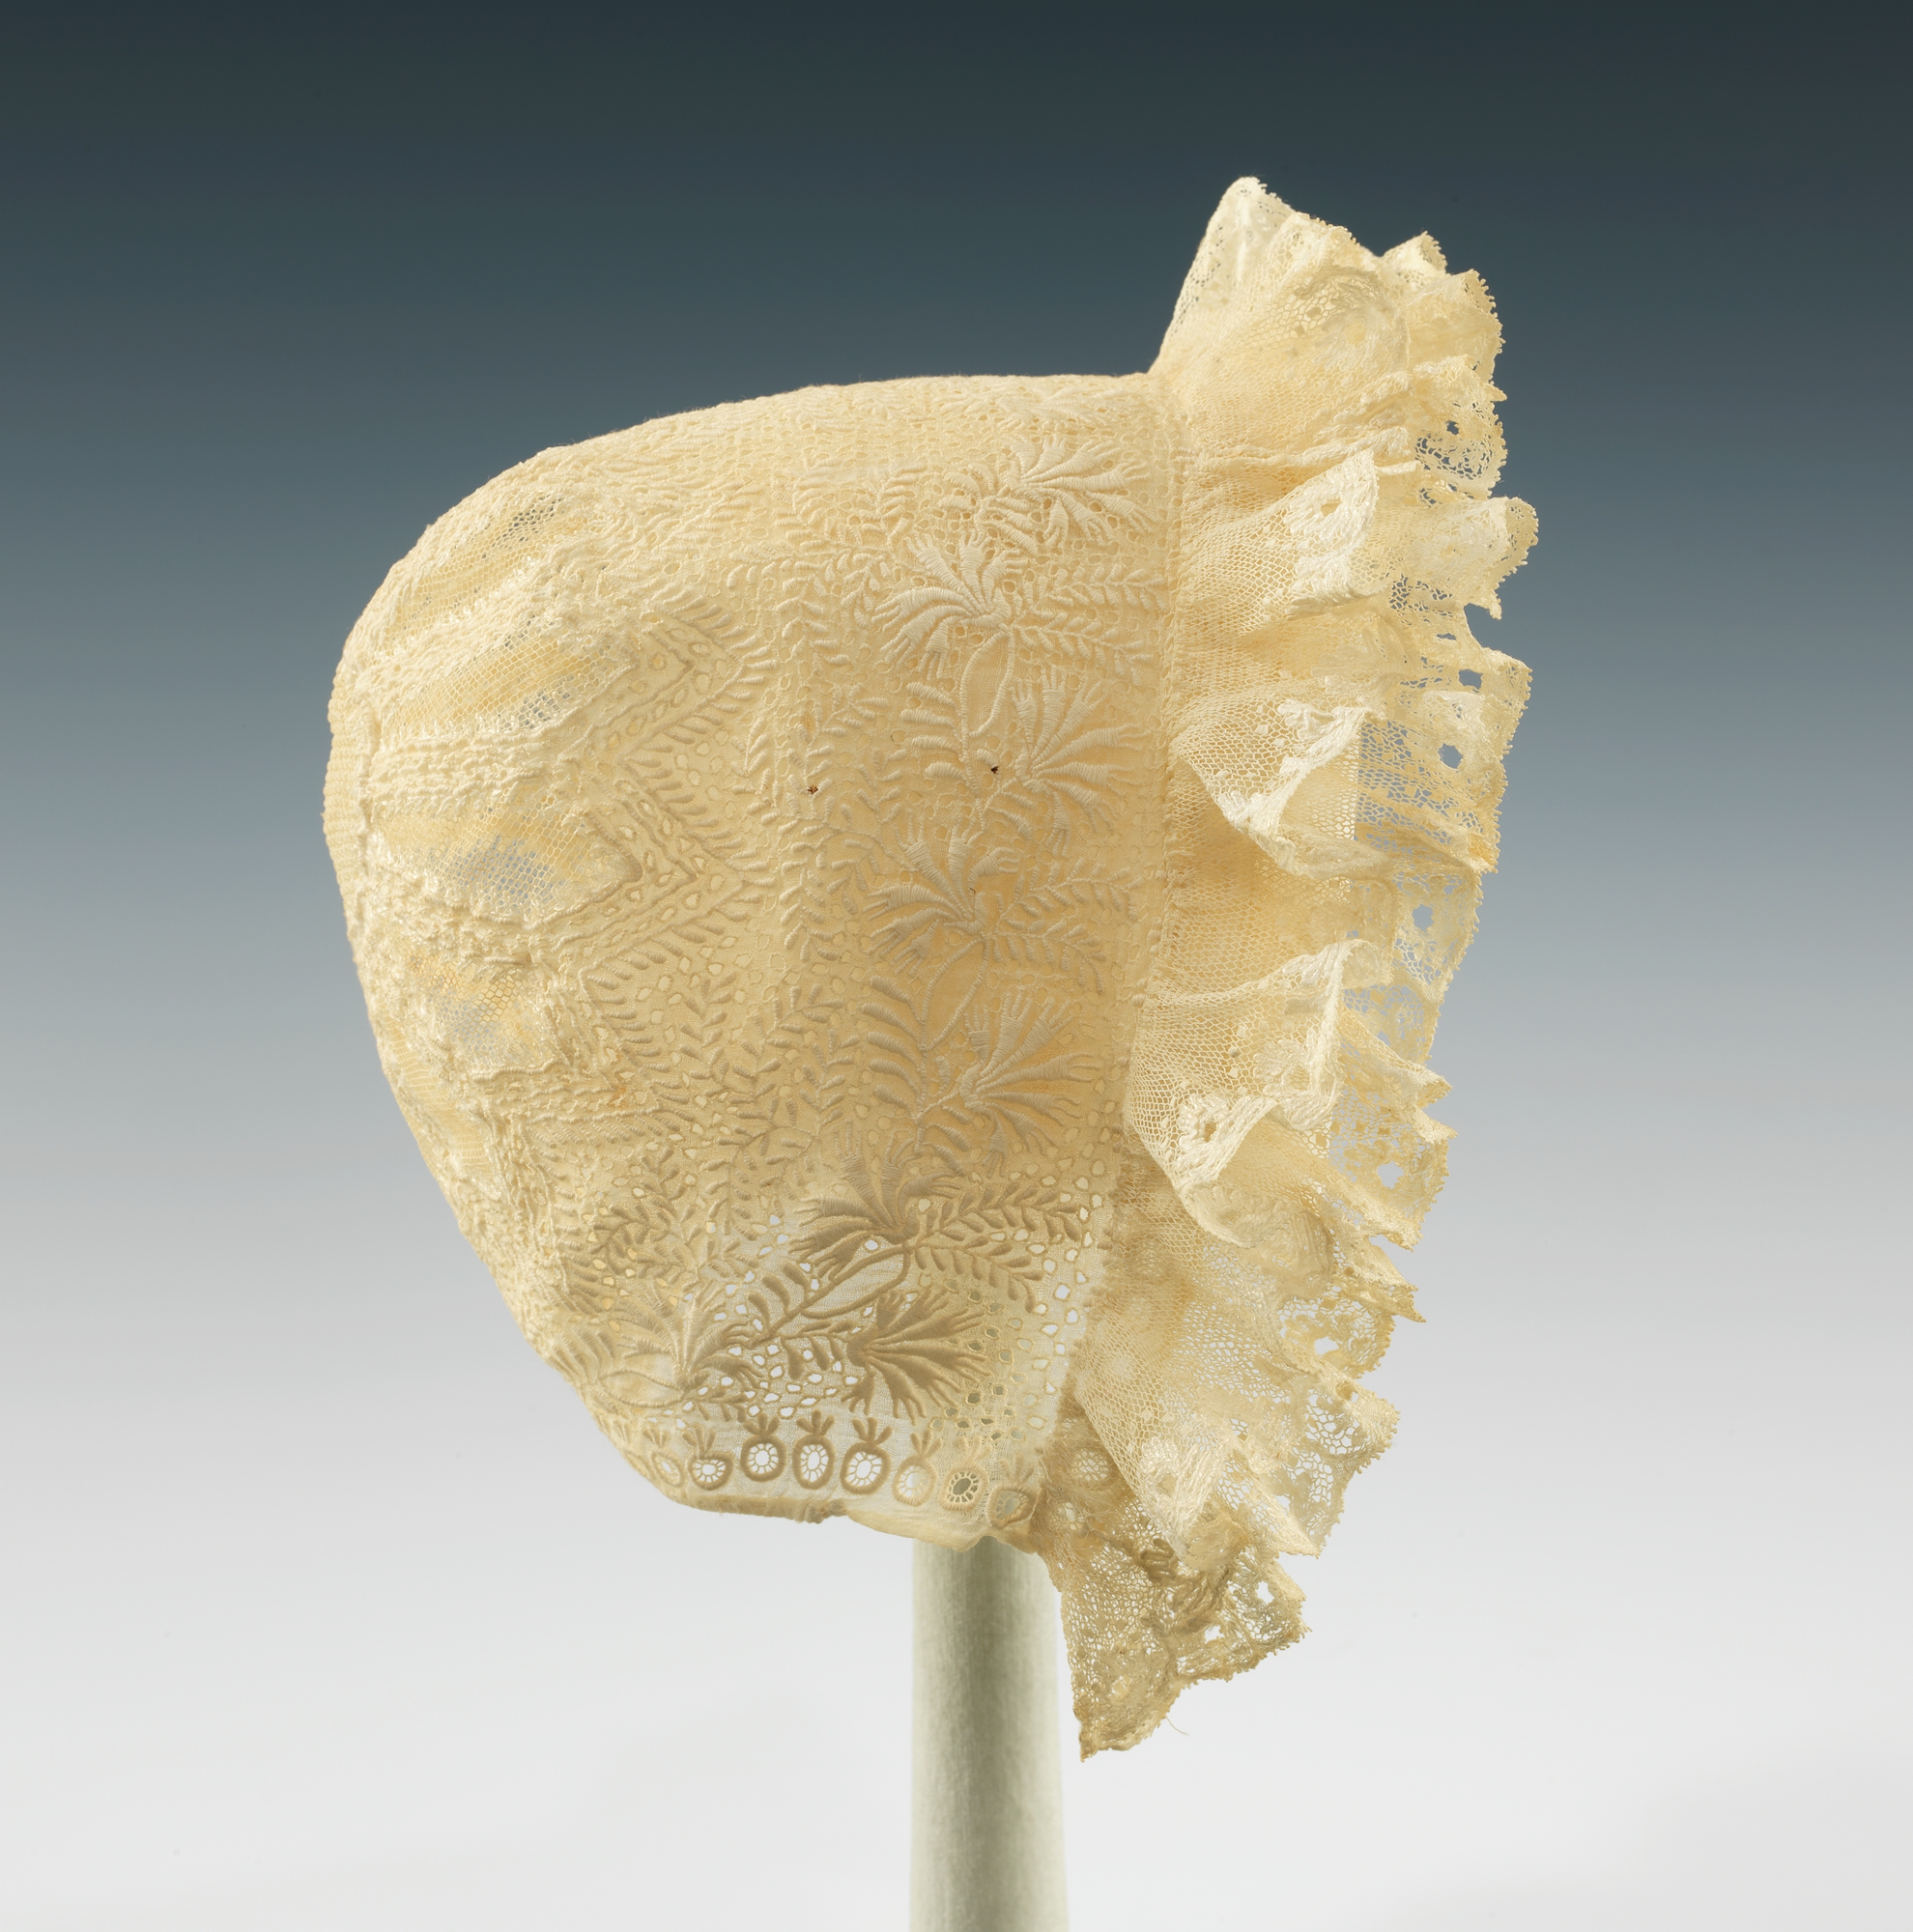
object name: cap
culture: american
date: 1829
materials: cotton